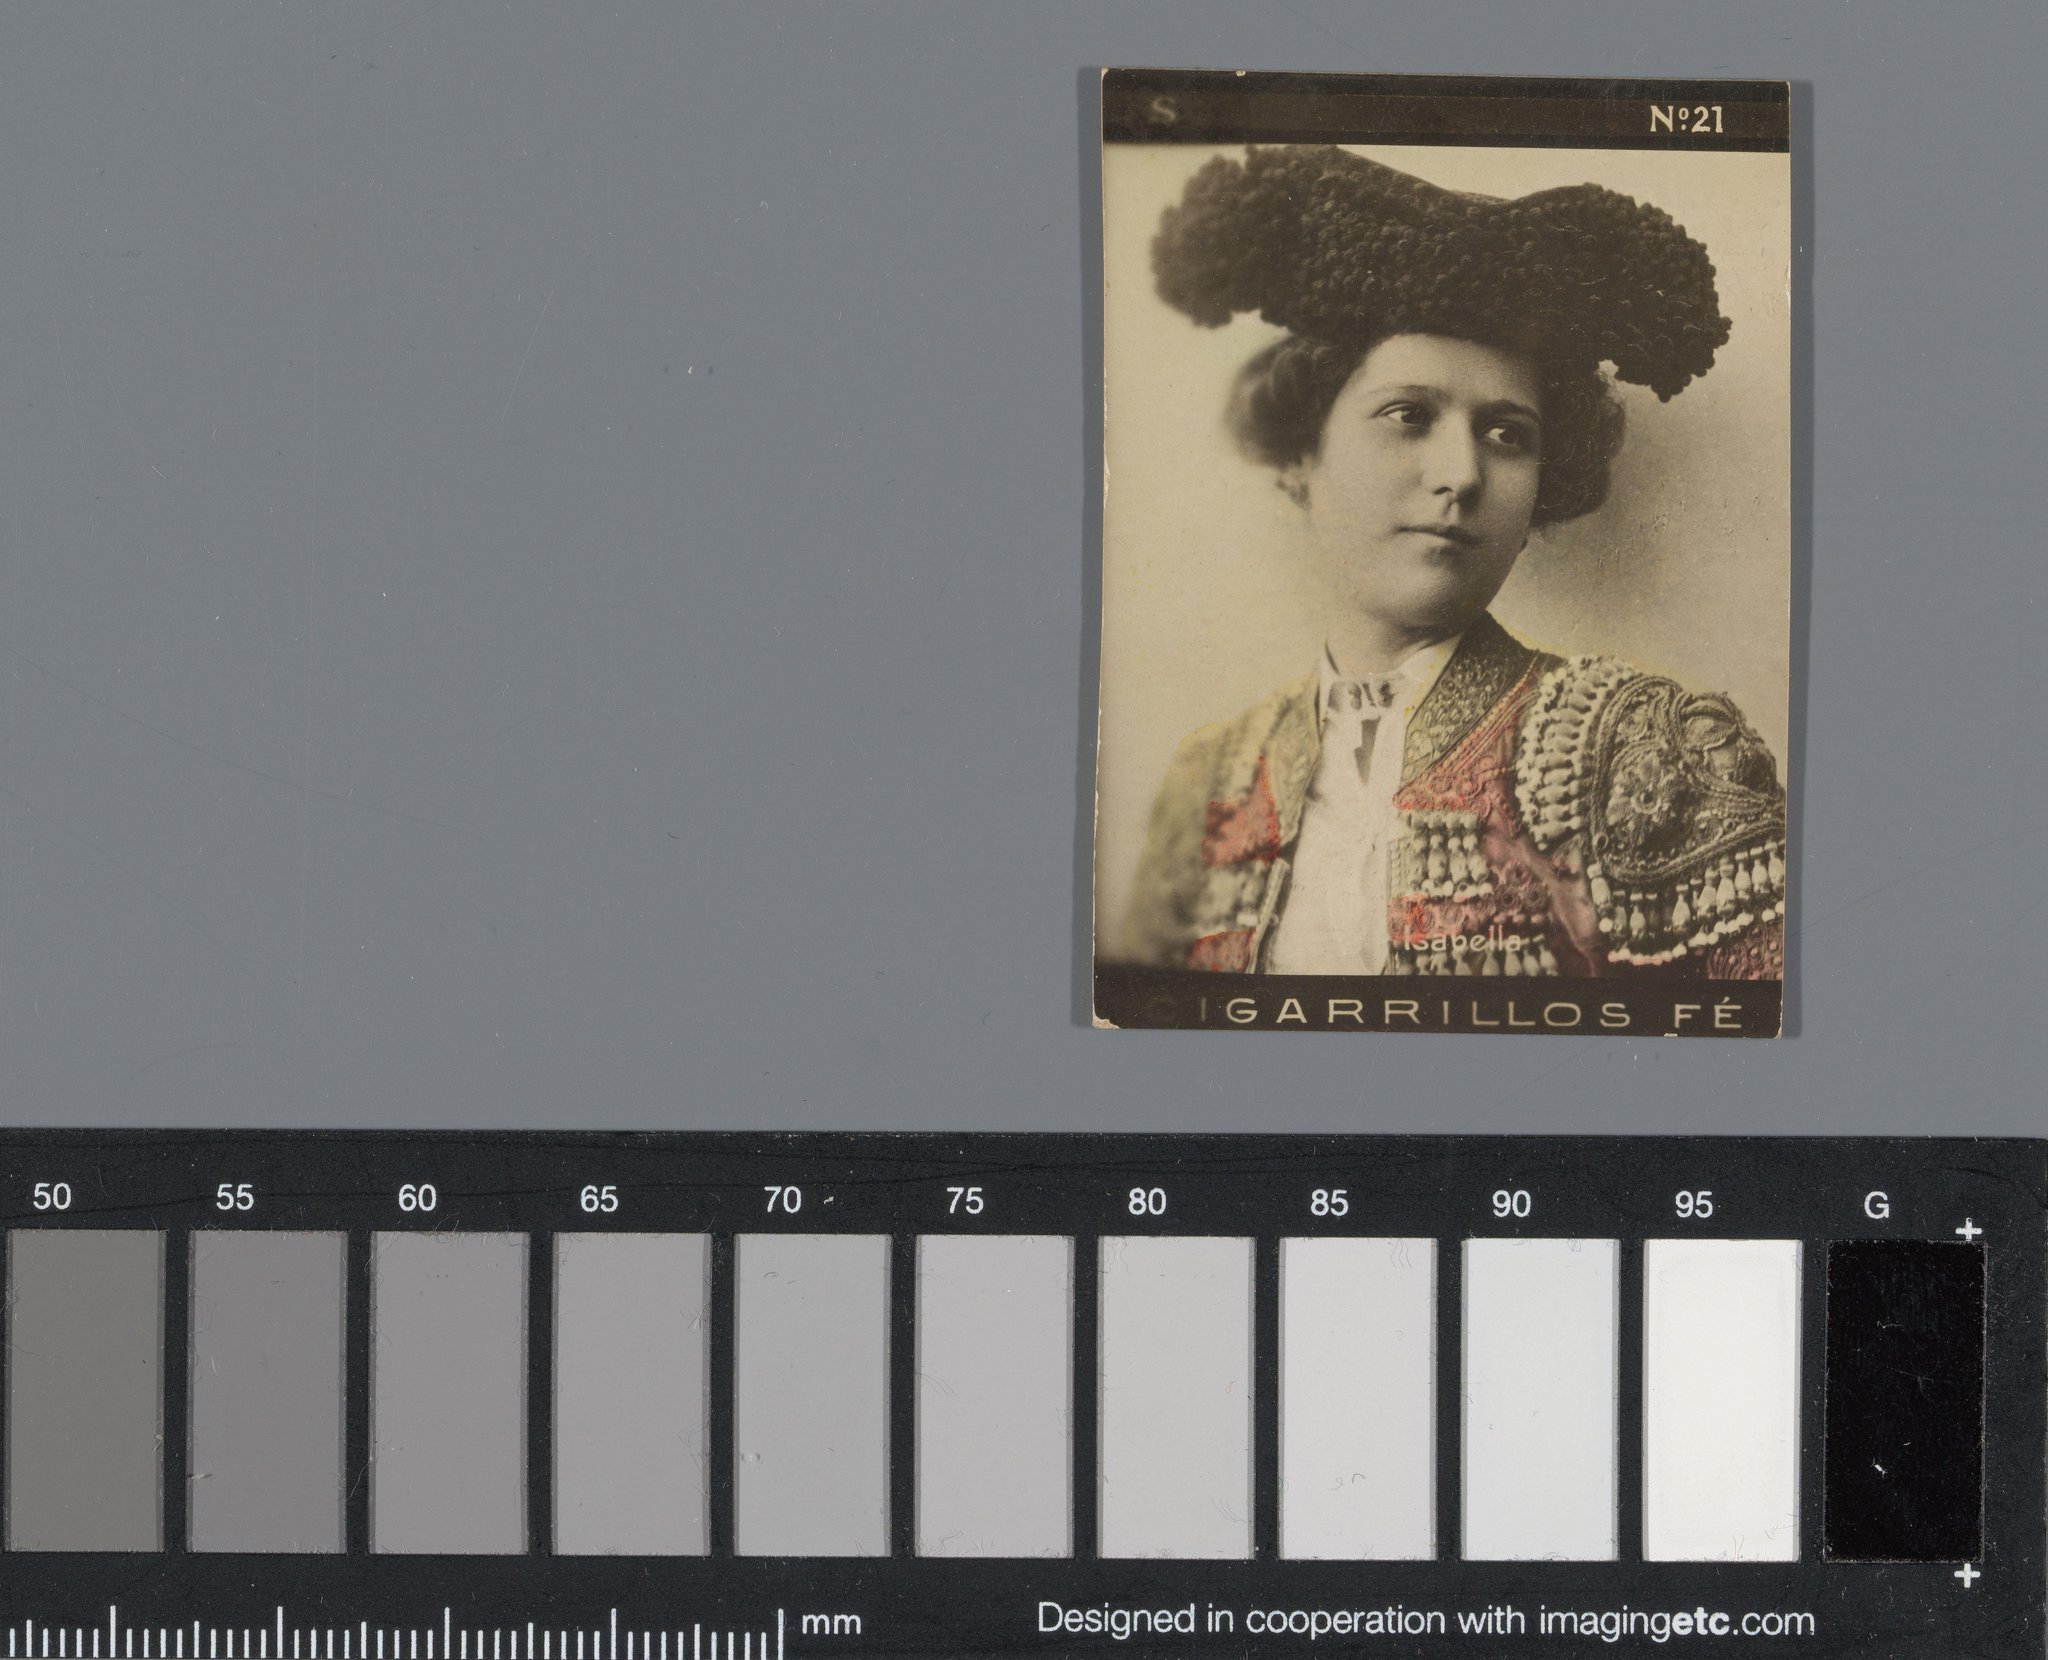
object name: photograph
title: Isabella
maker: Anonymous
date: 1890-1910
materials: photographic support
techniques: gelatin silver print, hand coloring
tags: historical persons - bb - woman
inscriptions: number: ‘No. 21’, inscription: ‘G. Meiboom’, inscription: ‘SIGARRILLOS FÉ’